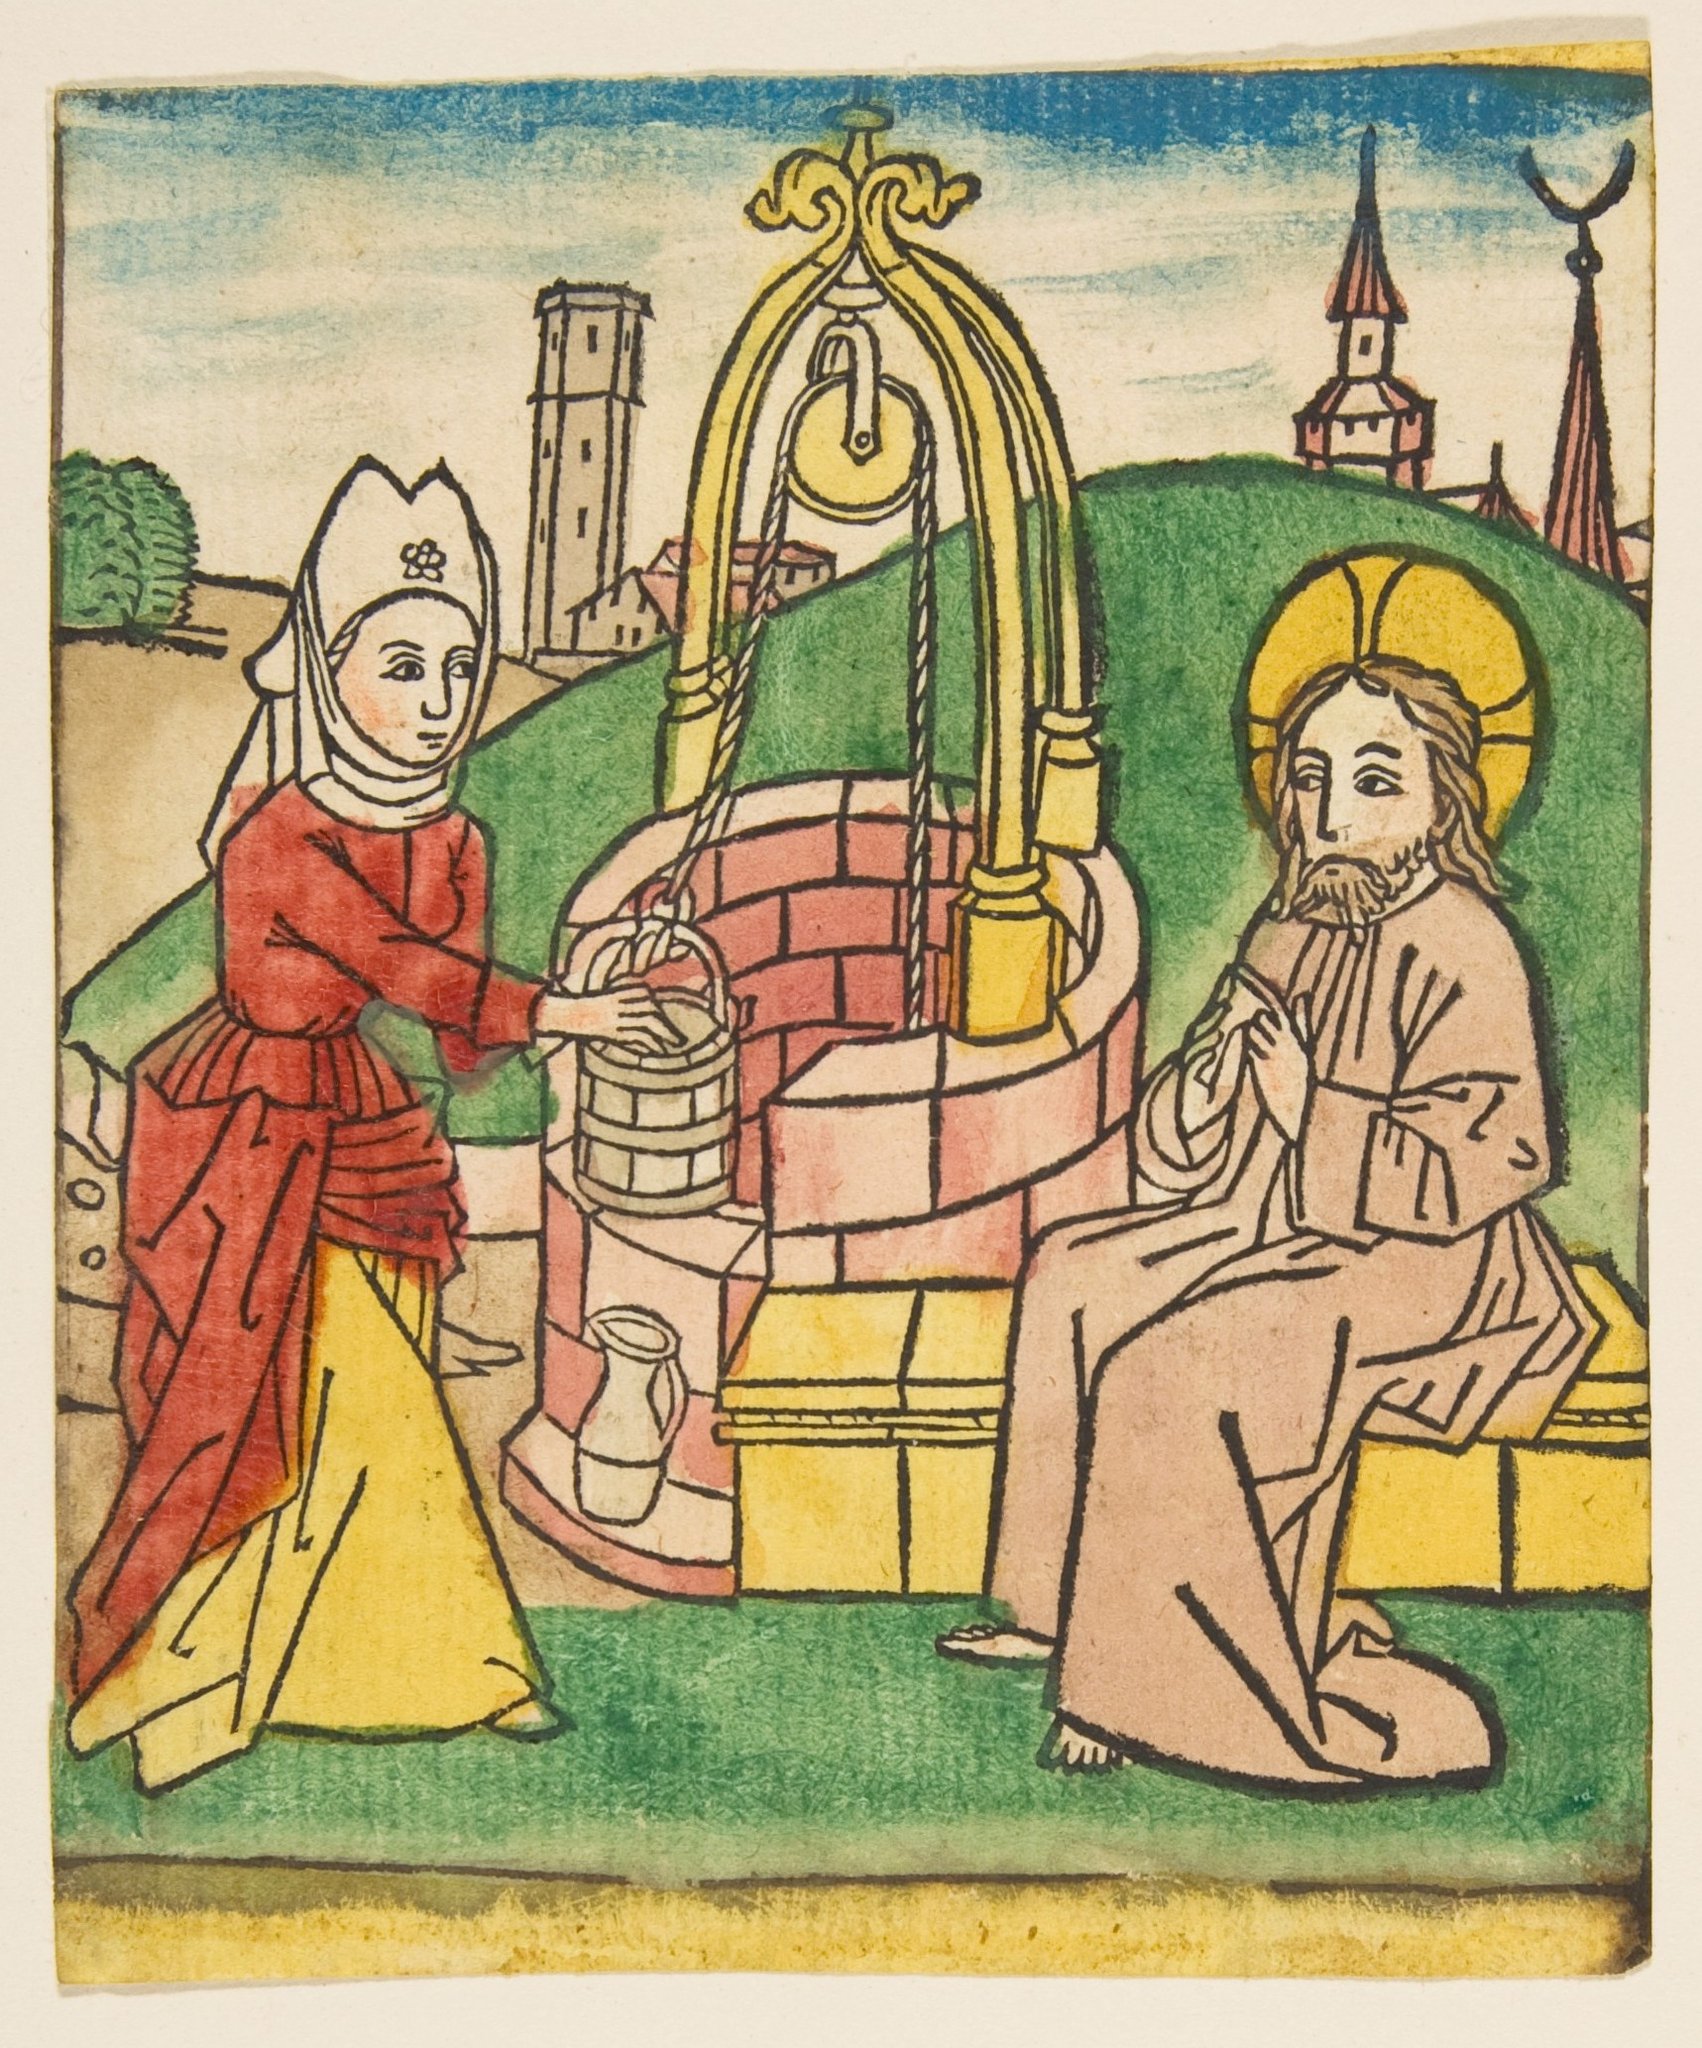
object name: print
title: Christ and the Woman of Samaria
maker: anonymous, german, 15th century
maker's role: artist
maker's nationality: german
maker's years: 1400-1500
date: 1401-1500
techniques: hand coloring, woodcut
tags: wells,women,christ